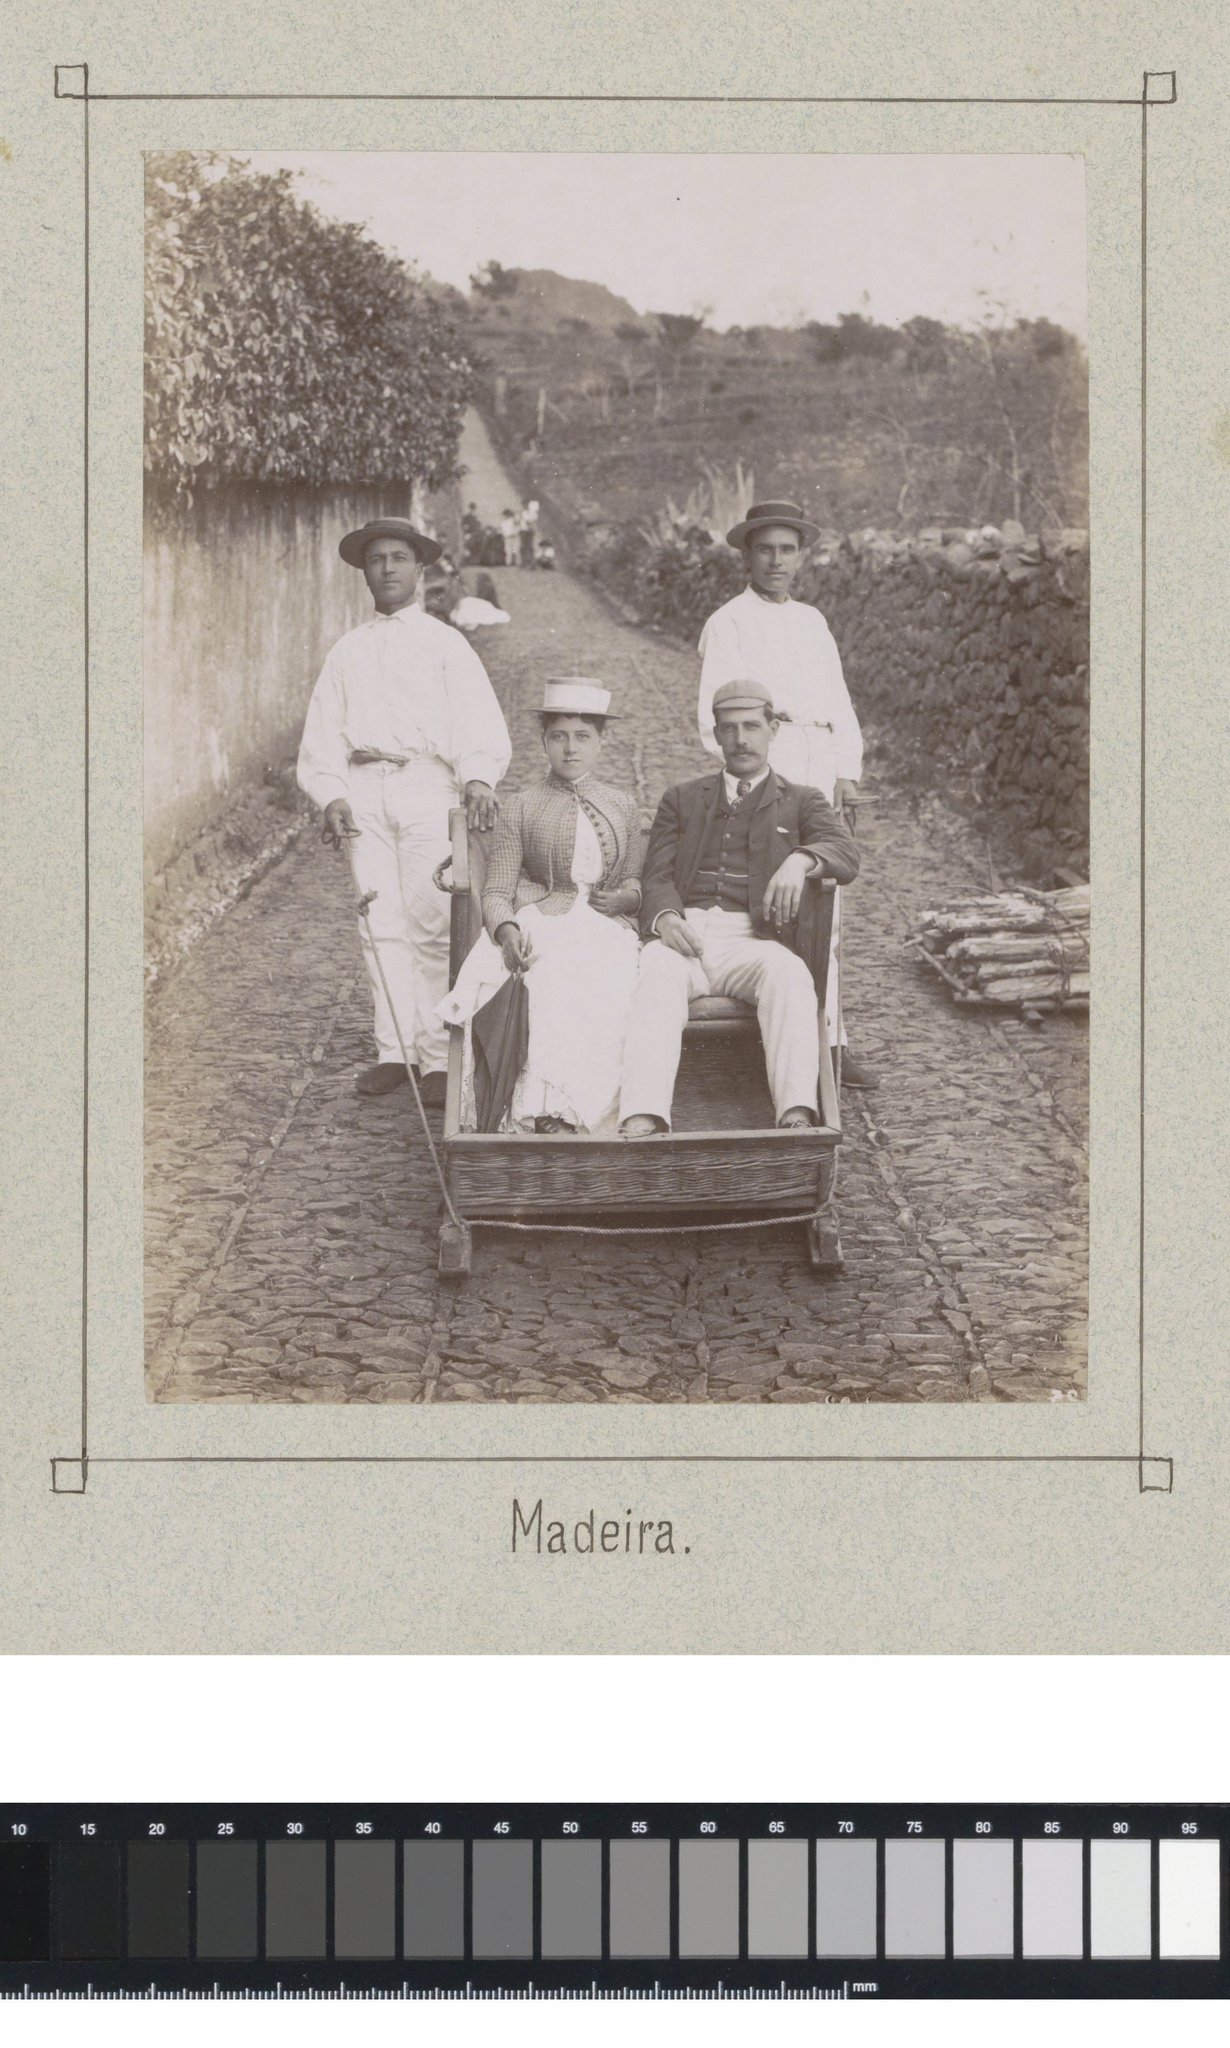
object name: photograph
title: Madeira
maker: Anonymous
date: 1880-1900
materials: photographic support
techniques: albumen print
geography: madeira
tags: animal-drawn sledge (dutch: 'toeslede')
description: Onderdeel van Reisalbum met foto's van Zuid-Afrika, Madeira, Portugal, Frankrijk en Duitsland.